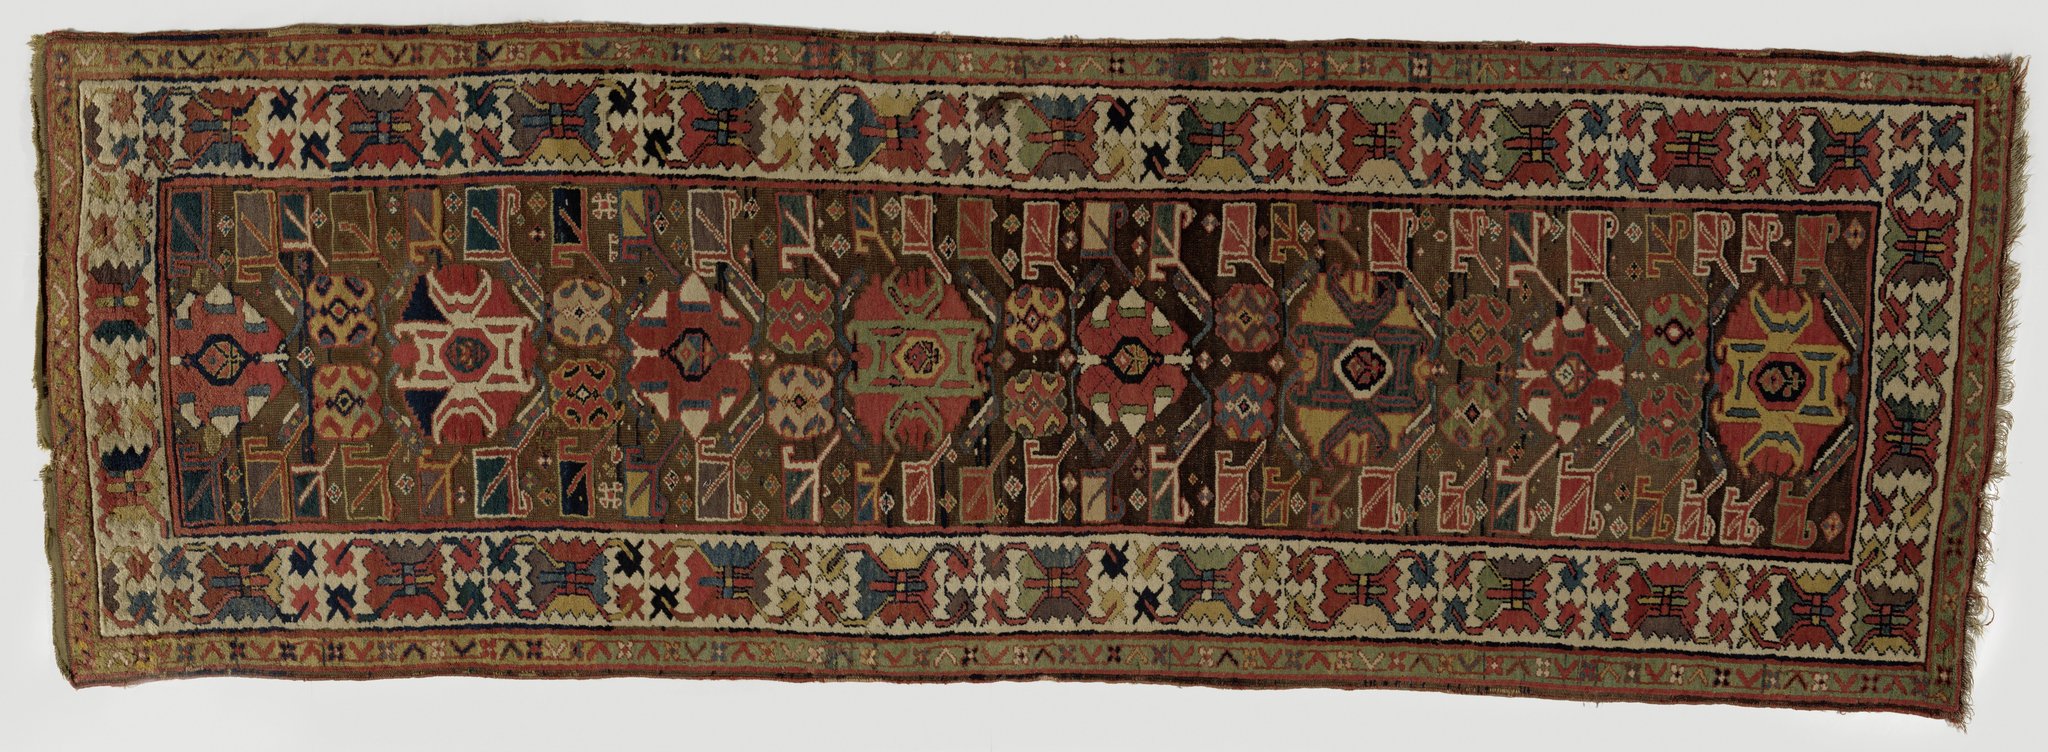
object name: oriental rug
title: Bloemenkleed met gestileerde bloemranken tegen donkerbruin fond met witte rand met zogenaamd krabbenornament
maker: Anonymous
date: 1850-1900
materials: wool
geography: kurdistan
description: Oosters tapijt, bloemenkleed. In het middenveld staan gestileerde bloemenranken tegen een donkerbruin fond. Witte rand met het zgn. krabbenornament.